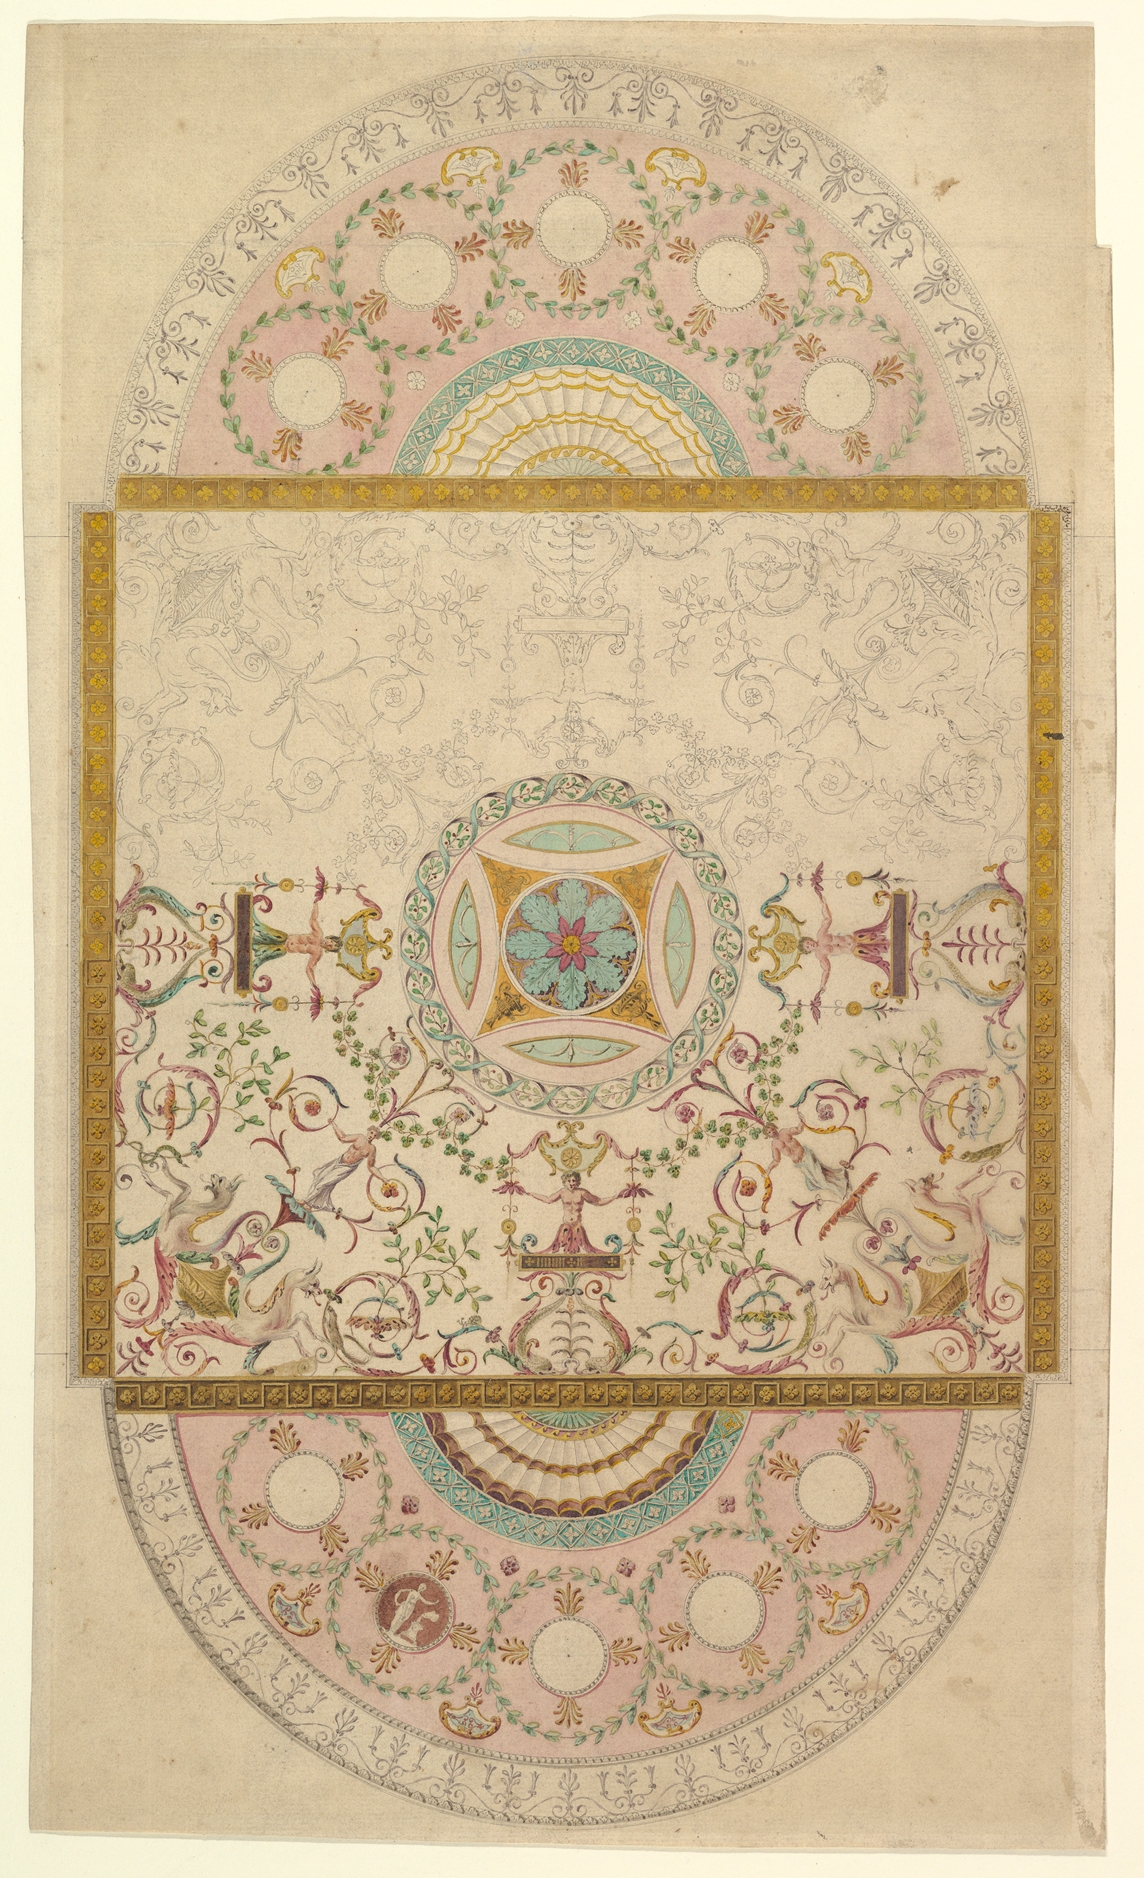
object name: drawing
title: Design for a Ceiling with Square Central Compartment and Semicircular Ends, the Ornament of Foliage and Grotesque Motifs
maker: anonymous, british, late 18th century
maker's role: artist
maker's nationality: british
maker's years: 1750-1800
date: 1767-1800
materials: ink, watercolor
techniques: pen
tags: grotesques,ornament